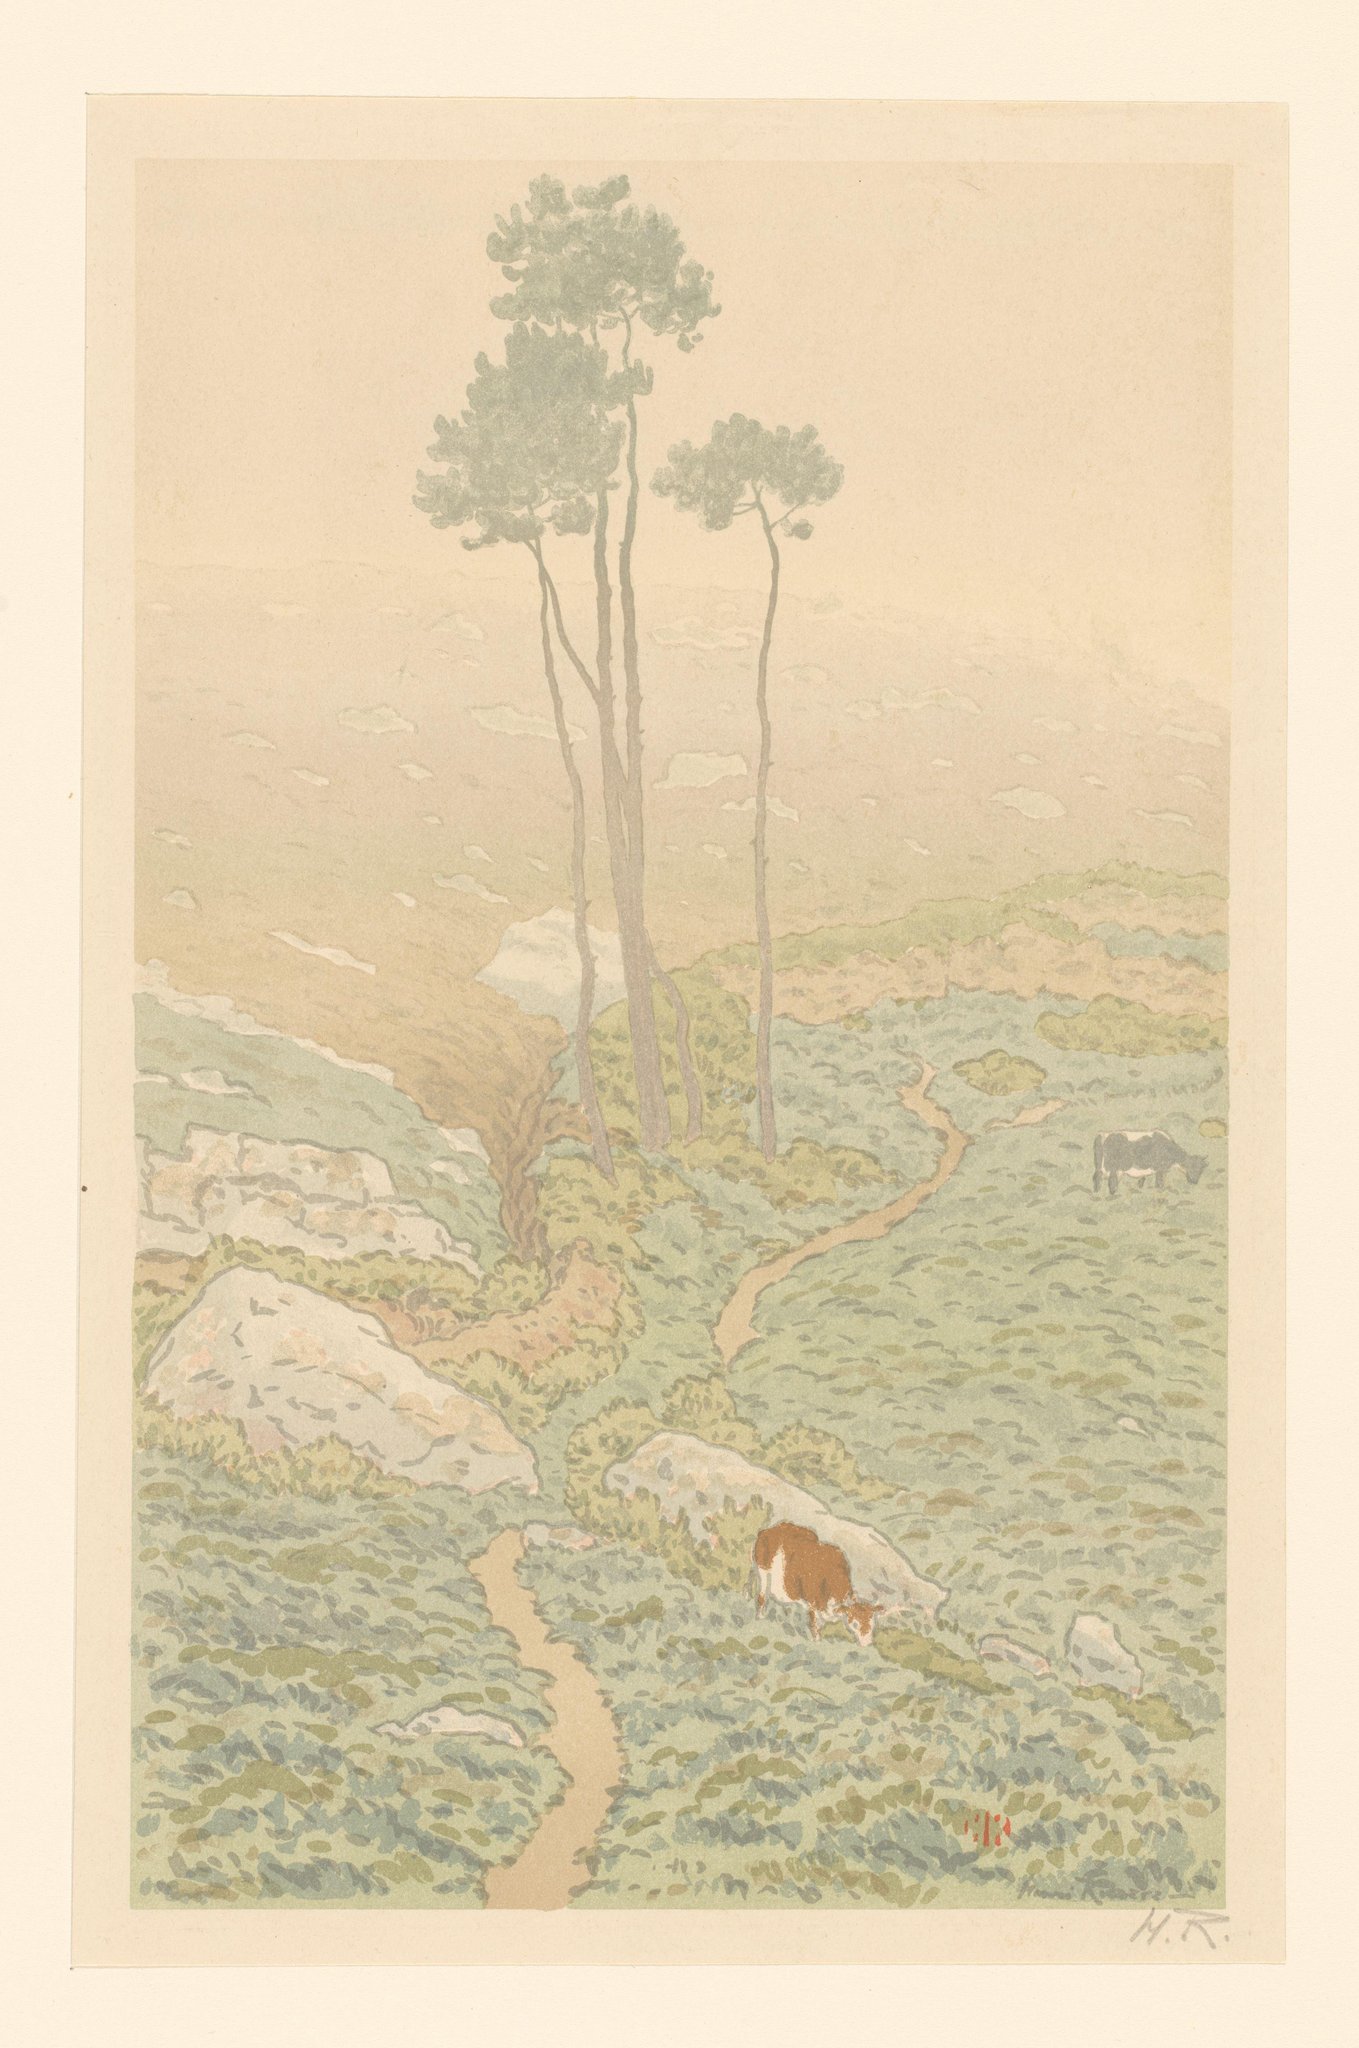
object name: print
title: Bretons landschap met koeien in de nevel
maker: henri rivière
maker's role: draughtsman, print maker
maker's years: 1864-1951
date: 1902-1951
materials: paper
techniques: lithograph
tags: landscapes, mist, fog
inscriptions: collector's mark: Lugt 2228, inscription: ‘Henri Rivière Brume matinale’, signature: ‘H.R.’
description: Het stempel van Henri Rivières monogram is meegedrukt. Zie: Toudouze, Georges. Henri Rivière. Peintre et Imagier. Parijs: Henri Floury, 1907, p. 177.